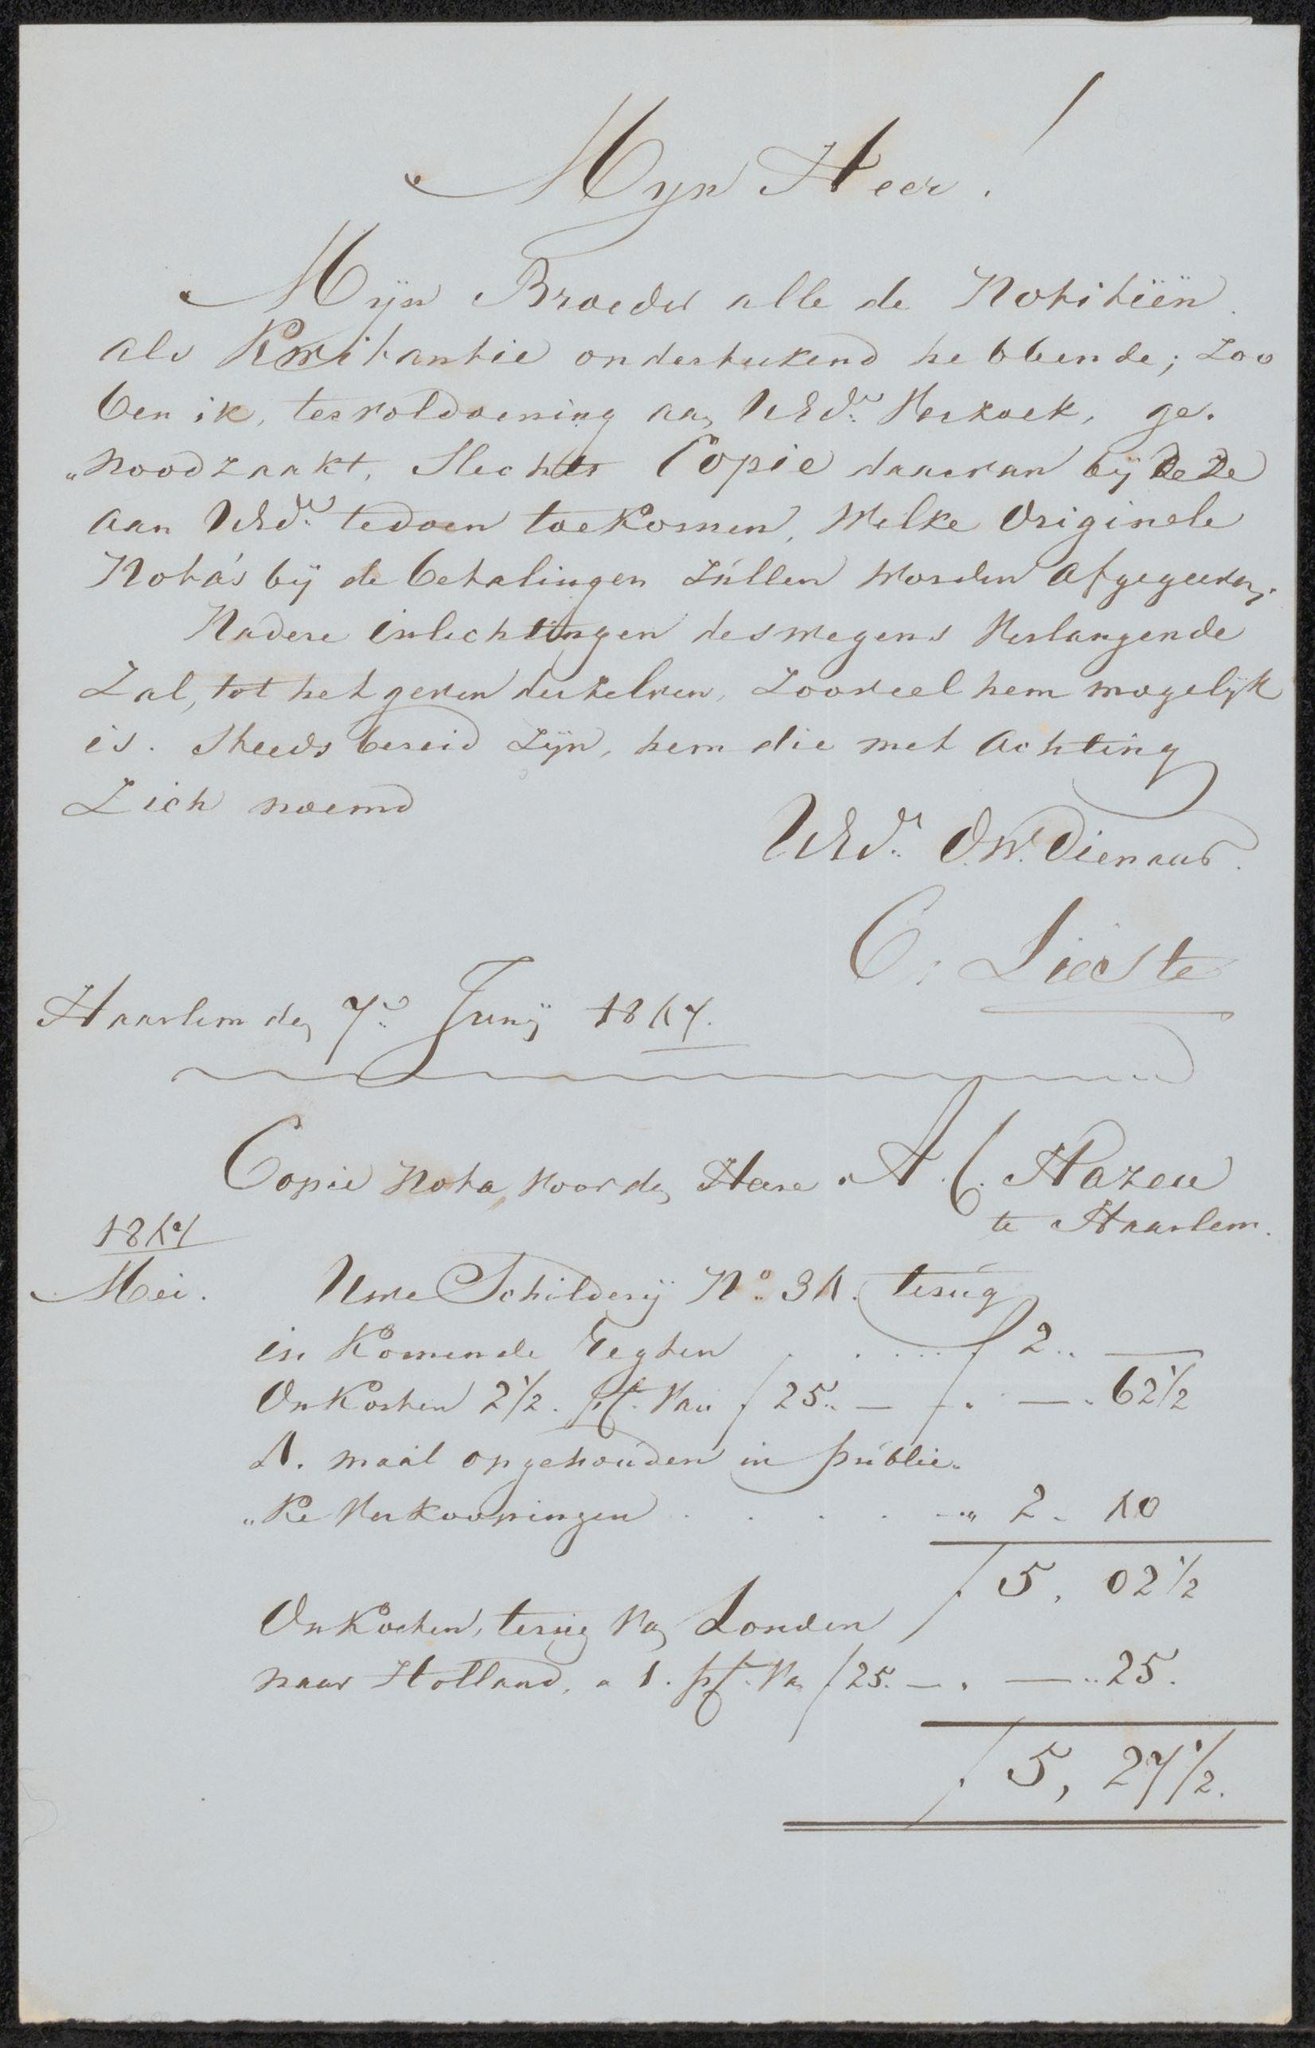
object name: letter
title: Brief aan Arend Cornelis Hazeu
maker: cornelis lieste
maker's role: draughtsman, print maker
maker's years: 1817-1861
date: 1847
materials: ink, paper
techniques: pen, writing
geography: haarlem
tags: abcoude, painter, arend cornelis hazeu, painting (including book-illumination, miniature-painting), money